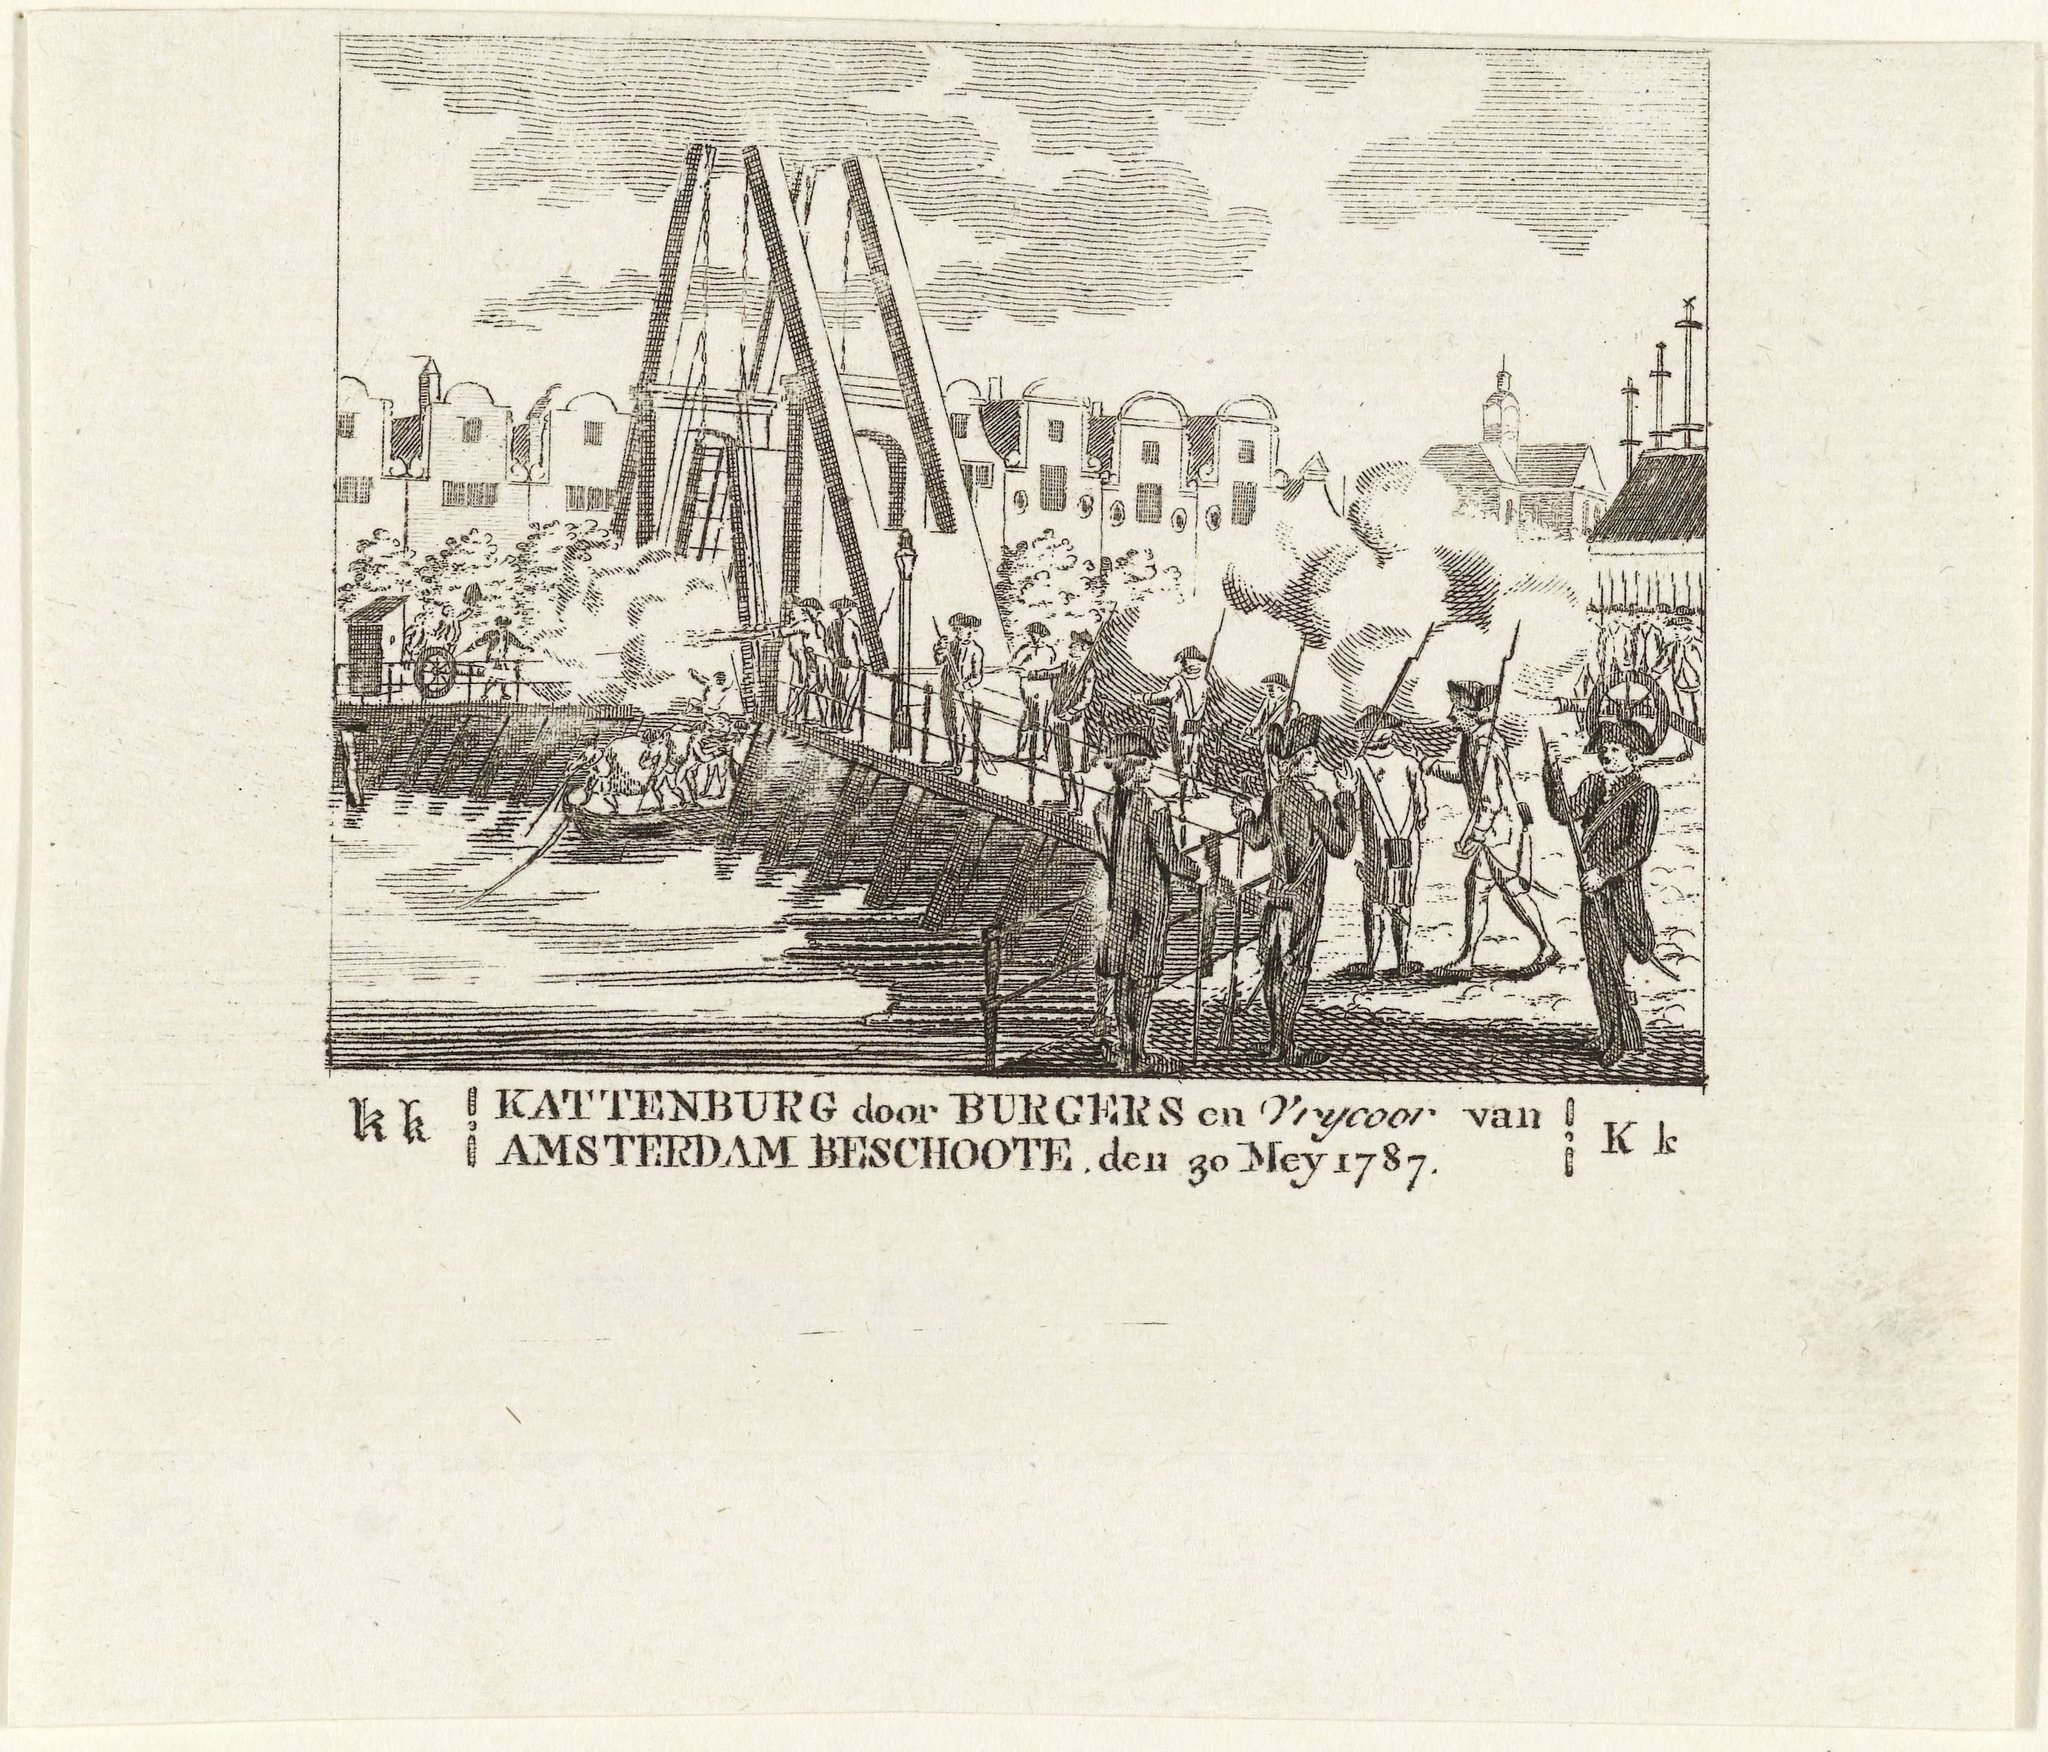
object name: print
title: Kattenburg door Burgers en Vrycoor van Amsterdam Beschoote. den 20 Mey 1787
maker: Anonymous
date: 1787-1790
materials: paper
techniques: engraving, etching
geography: northern netherlands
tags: battle (+ citizen soldiery, civil guard, citizen militia)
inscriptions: collector's mark: Lugt 2228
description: Gebruikt als illustratie in: Vorstelyke koninglyke en princelyke atlas, en dagboek van Nederlandsche gebeurtenissen, in de laatste jaaren voorgevallen. En oprecht vaderlandsch (...) A.B. boek. Amsterdam: Willem Coertse, [1790].. Niet in Frederik Muller; door het RPK toegevoegd nummer.